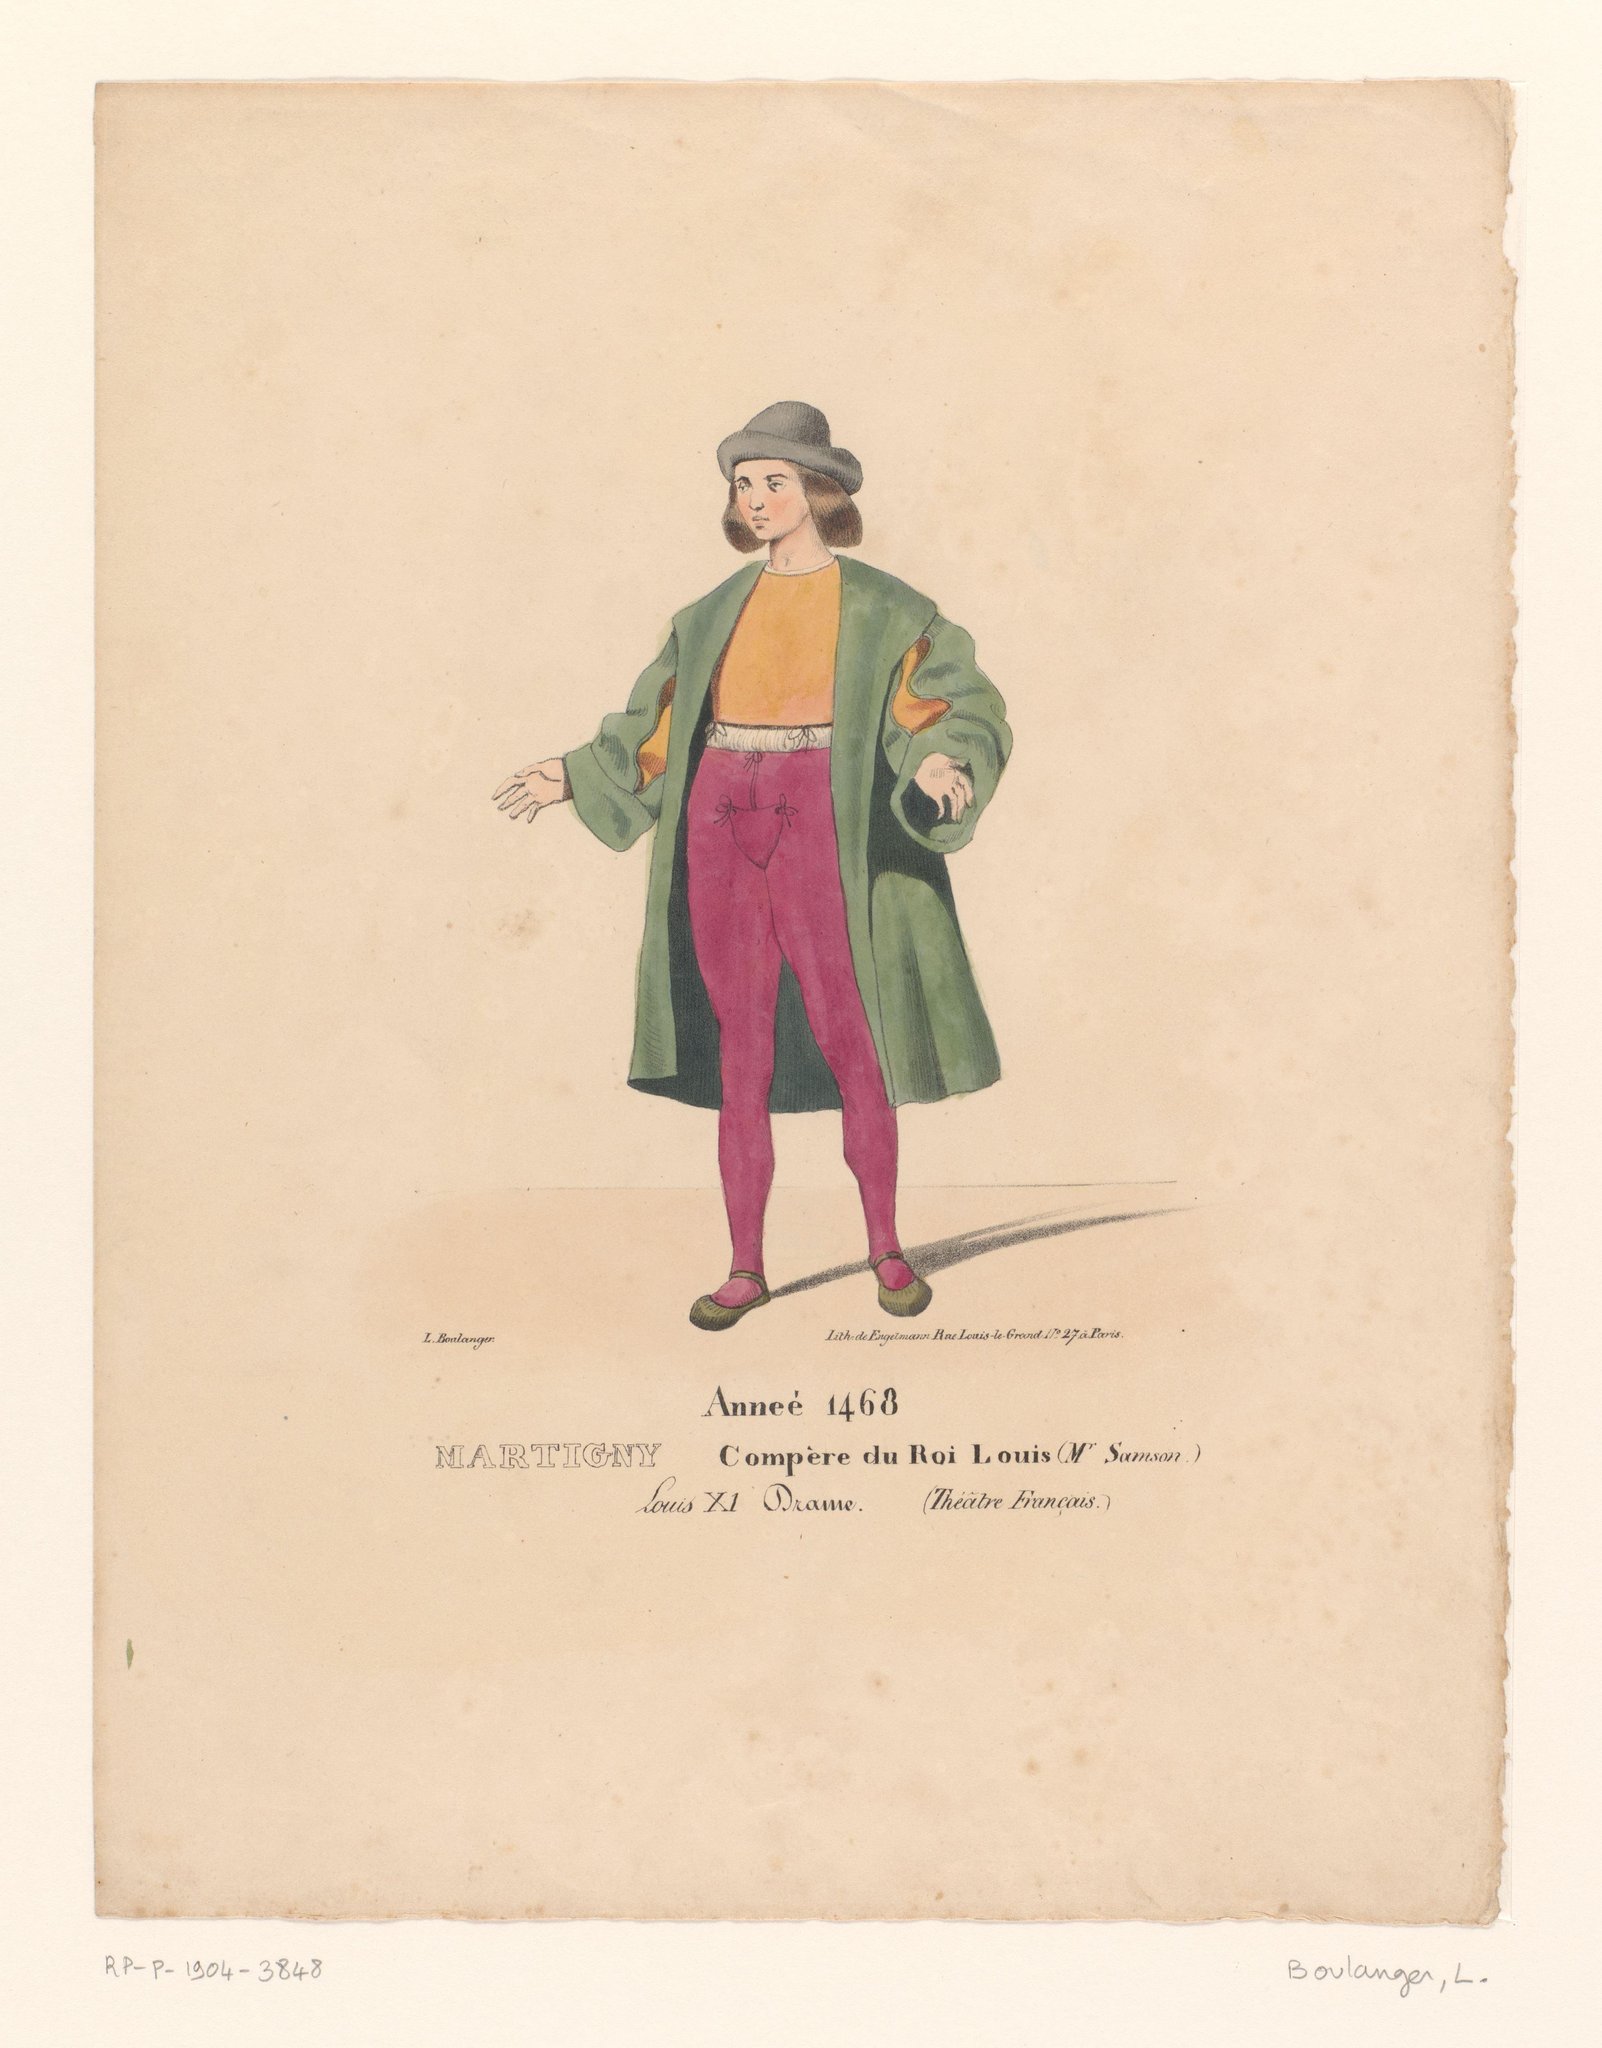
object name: print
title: Martigny, Compère du Roi Louis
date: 1826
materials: paper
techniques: hand coloring, lithograph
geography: paris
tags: stage costume, actor (on the stage), tragedy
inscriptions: collector's mark: Lugt 2228a